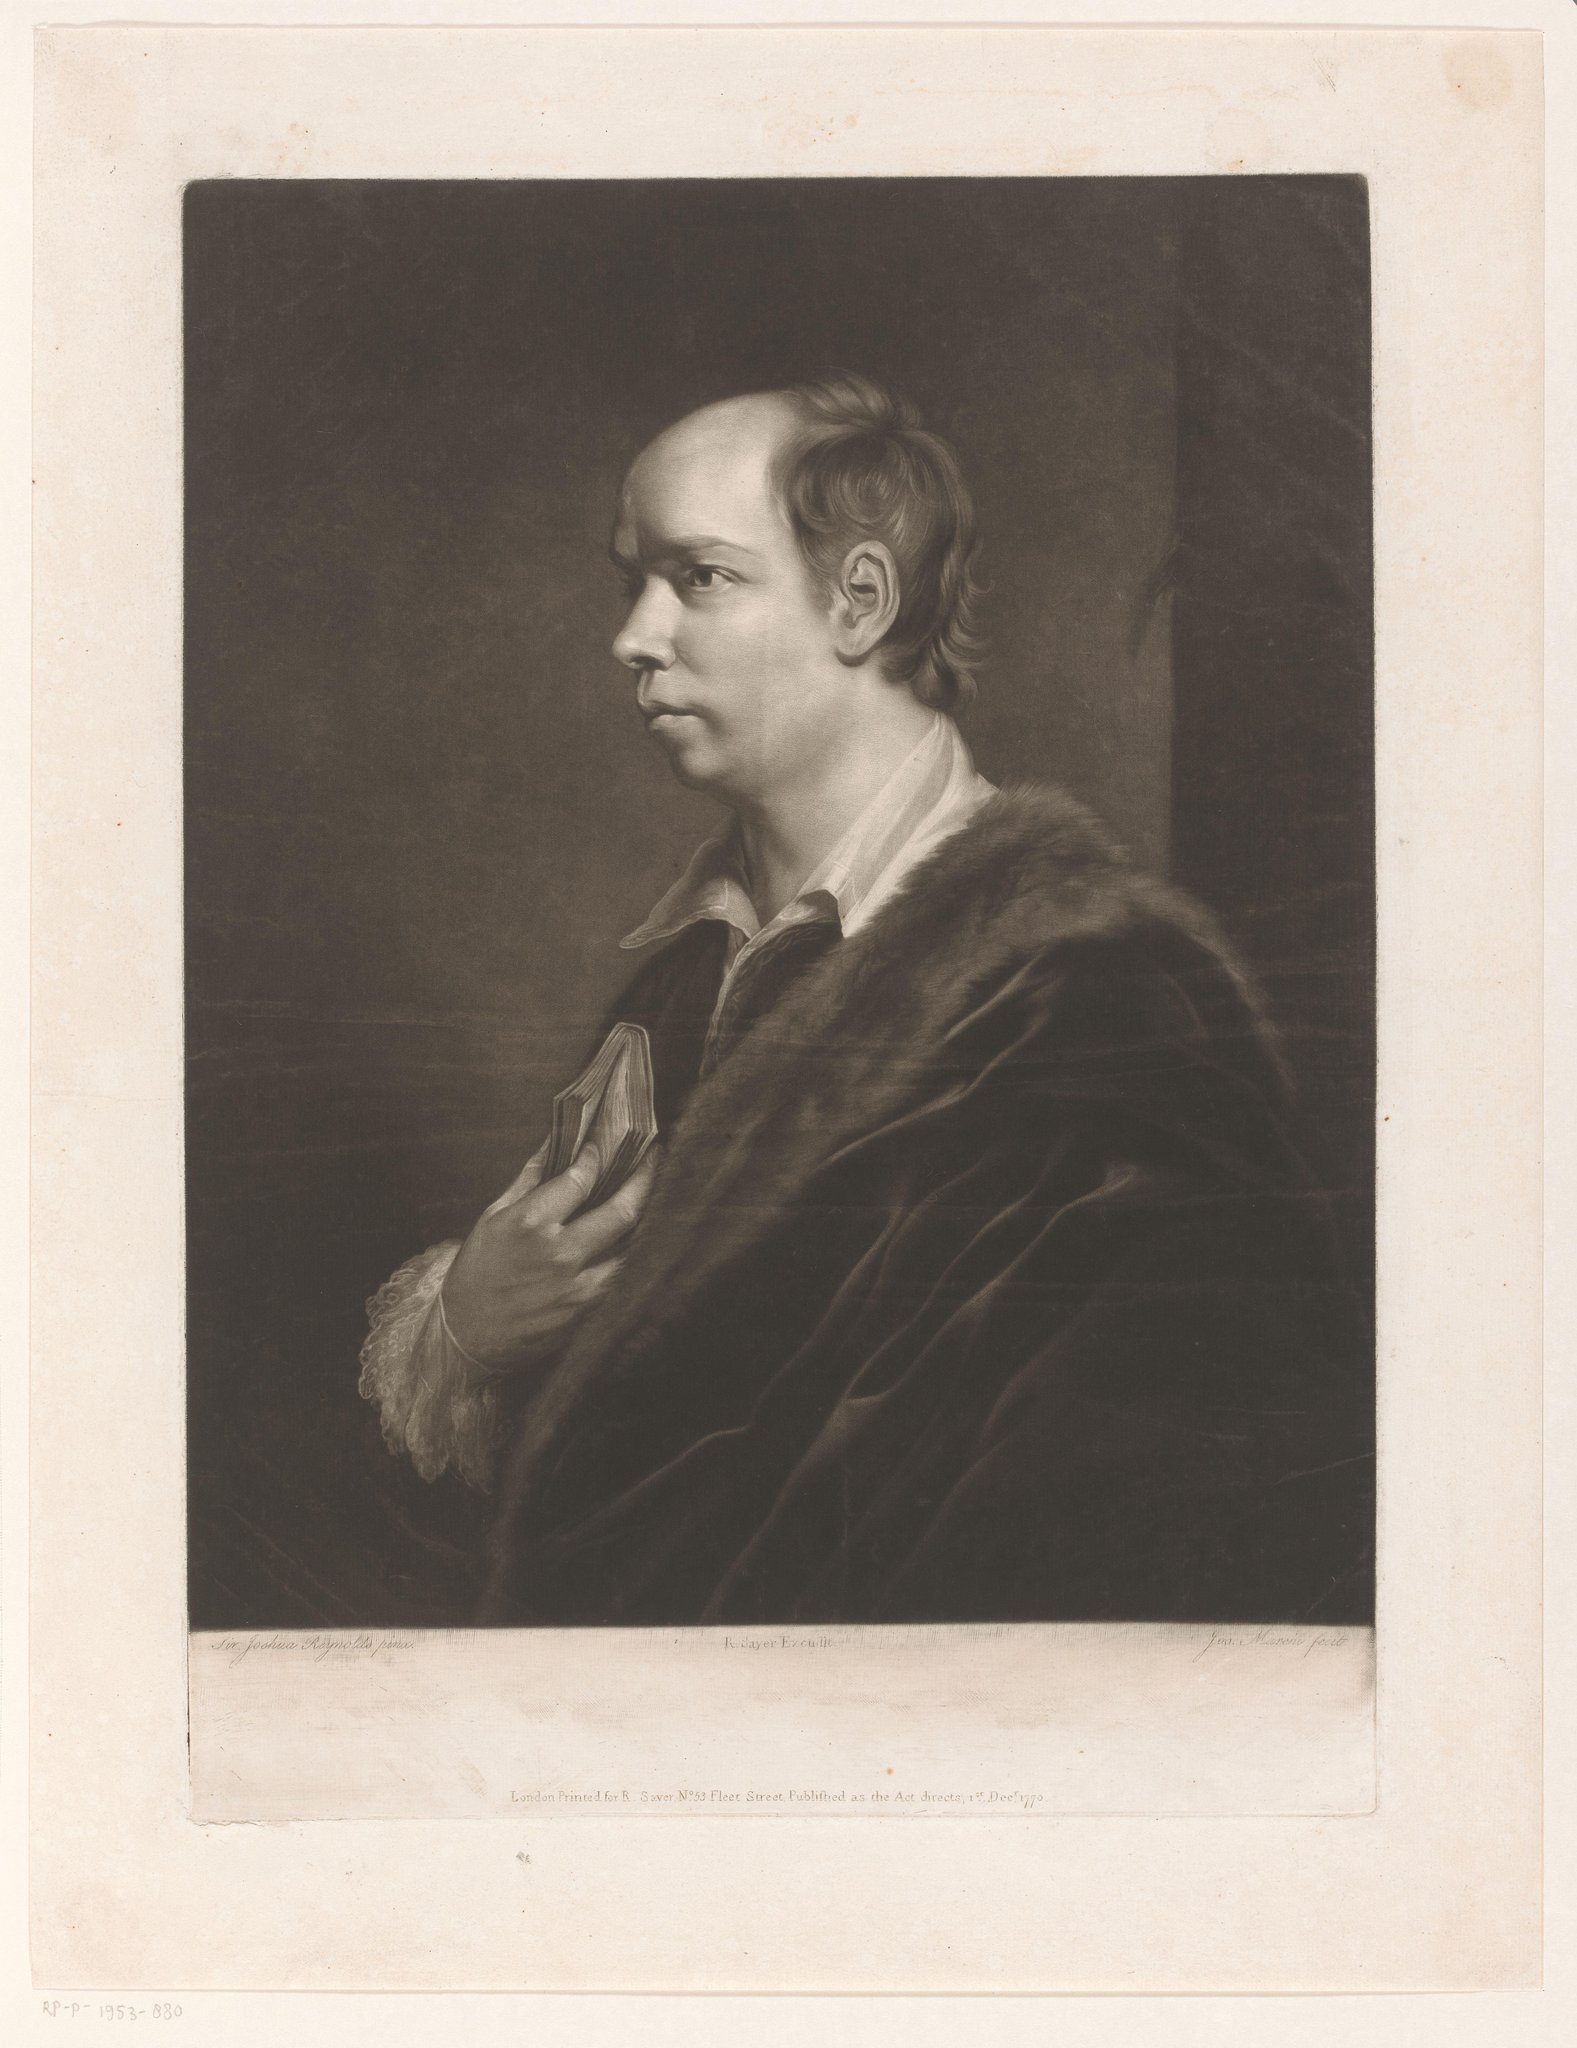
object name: print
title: Portret van Oliver Goldsmith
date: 1770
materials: paper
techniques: mezzotint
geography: london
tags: london, oliver goldsmith, historical persons, portrait of a writer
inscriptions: collector's mark: Lugt 2760, collector's mark: Lugt 2228